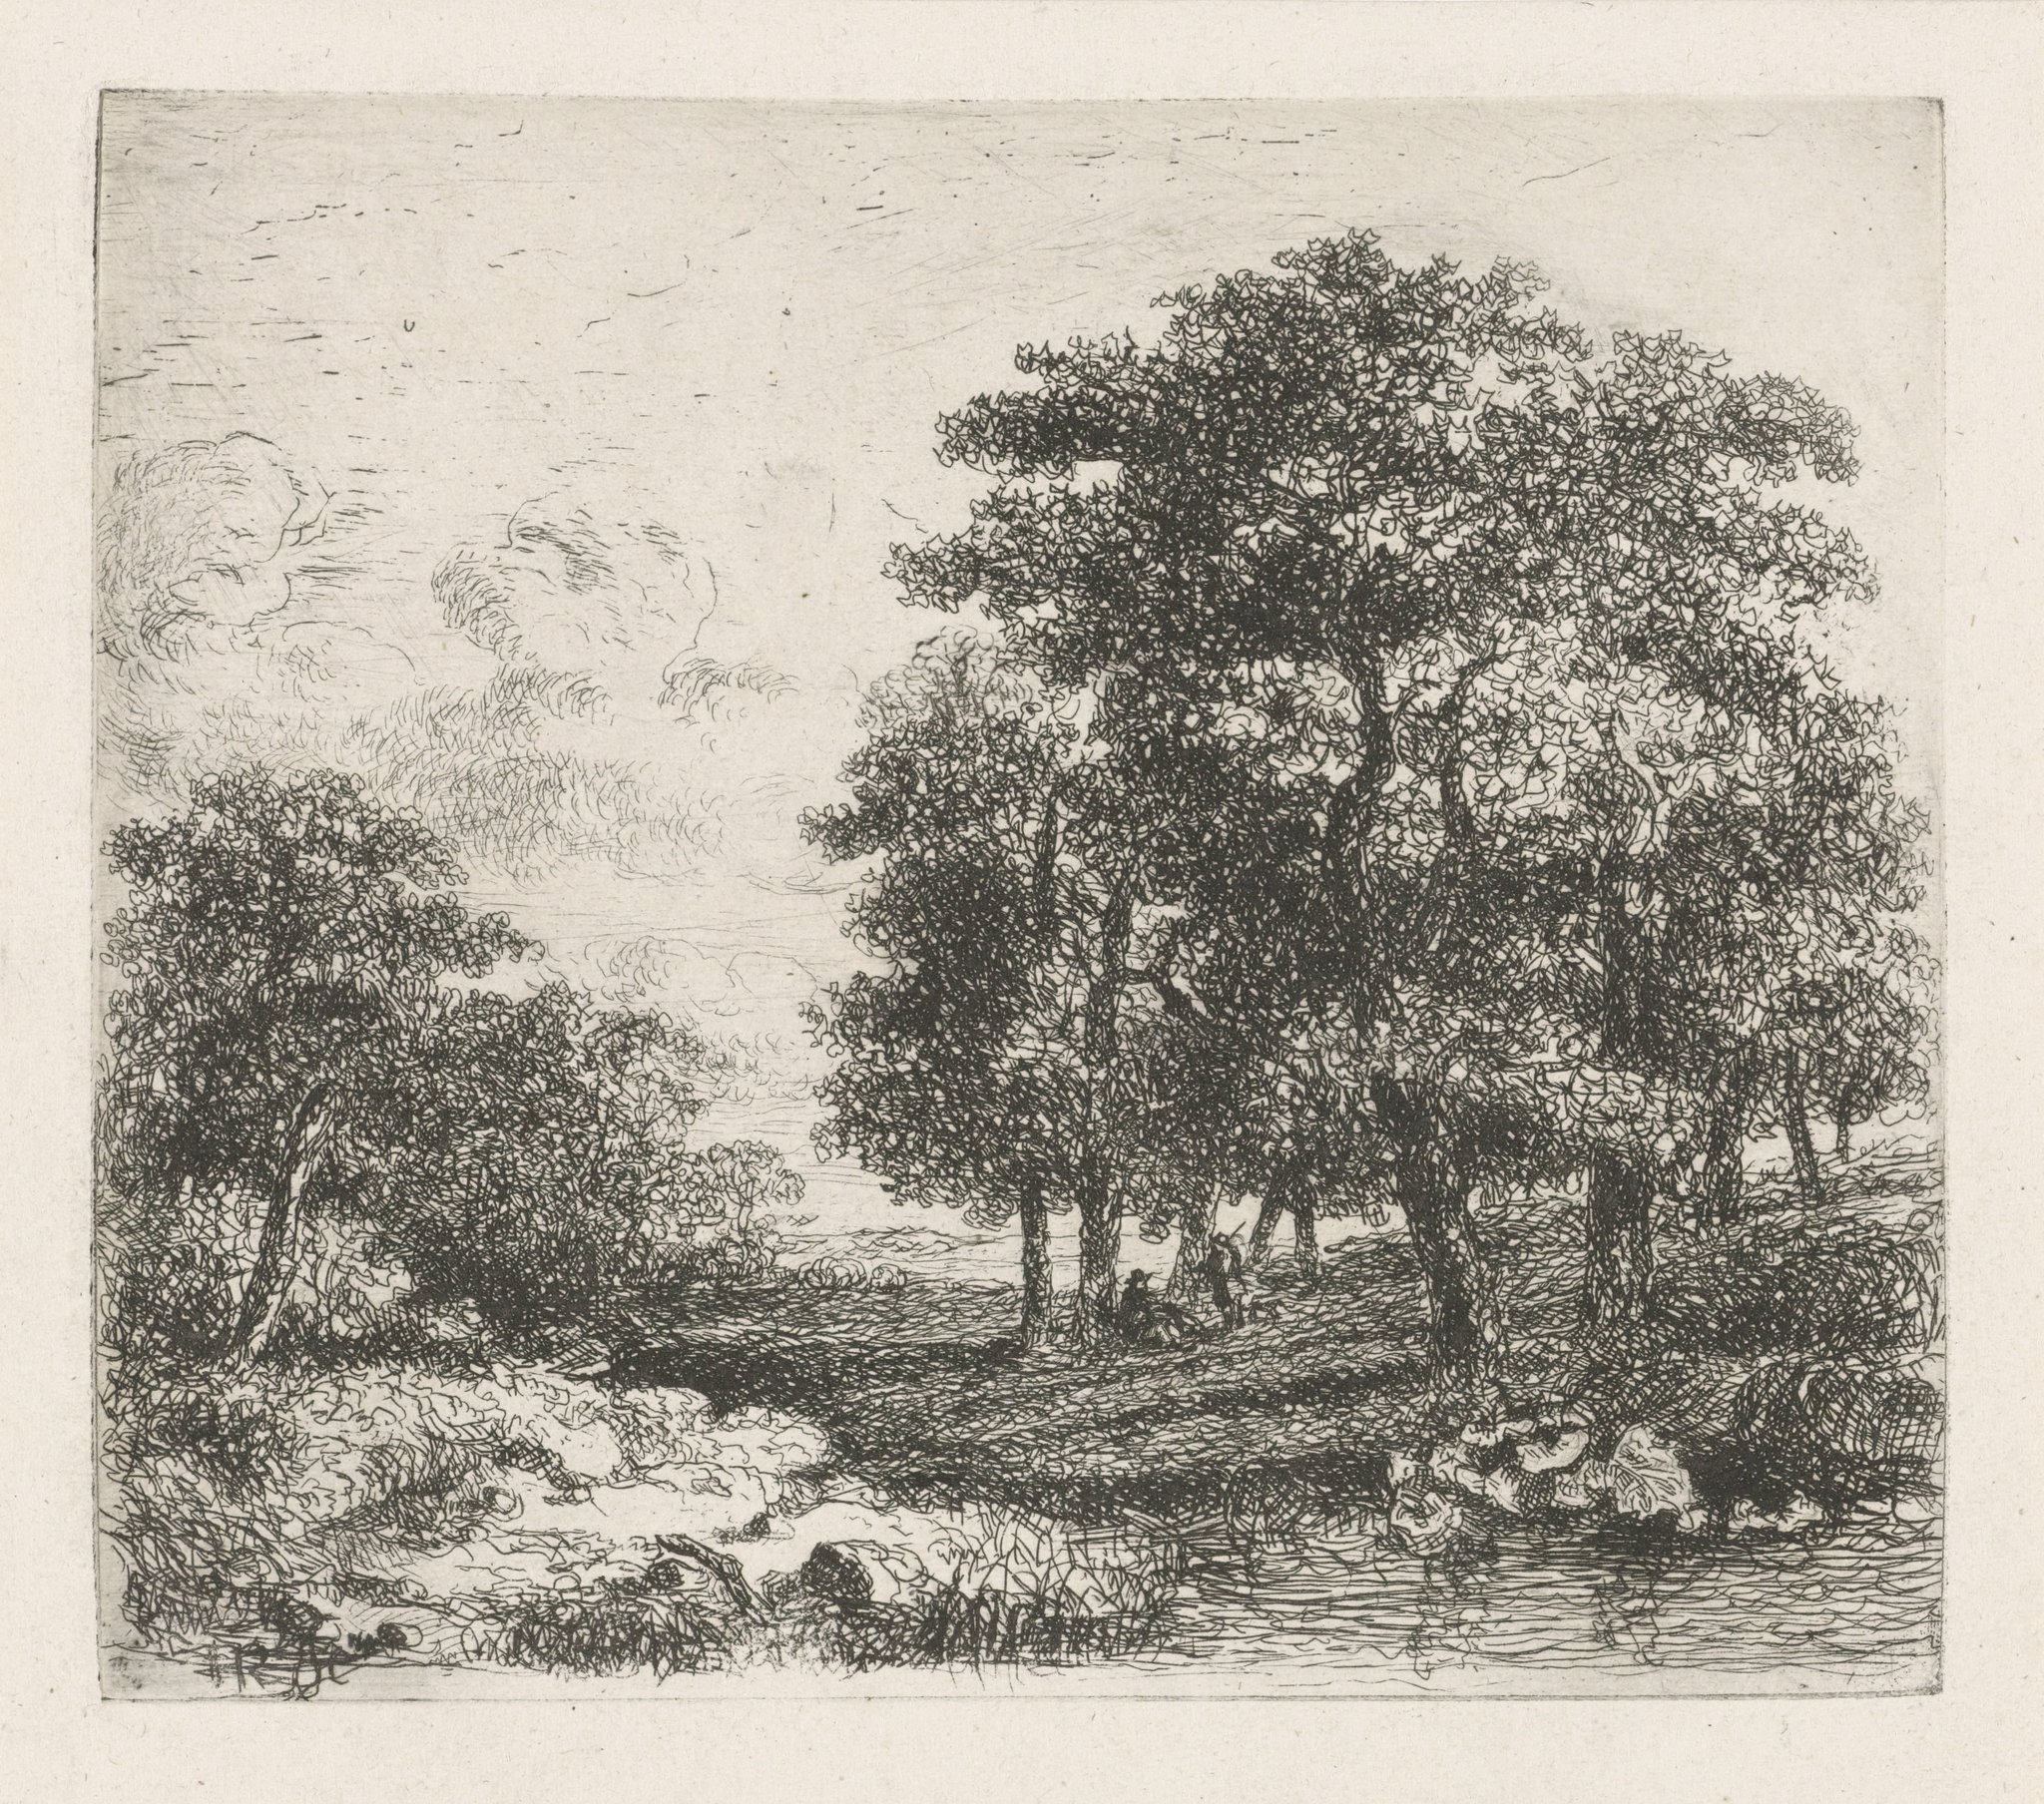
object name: print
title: Boomrijk landschap met twee converserende mannen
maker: hermanus jan hendrik van rijkelijkhuysen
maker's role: painter, print maker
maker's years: 1813-1883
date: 1823-1883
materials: paper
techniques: drypoint, etching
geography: utrecht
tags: swamp, inland marsh, fens (+ landscape with figures, staffage), trees, conversation, dialogue; conversation piece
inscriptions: collector's mark: Lugt 2228